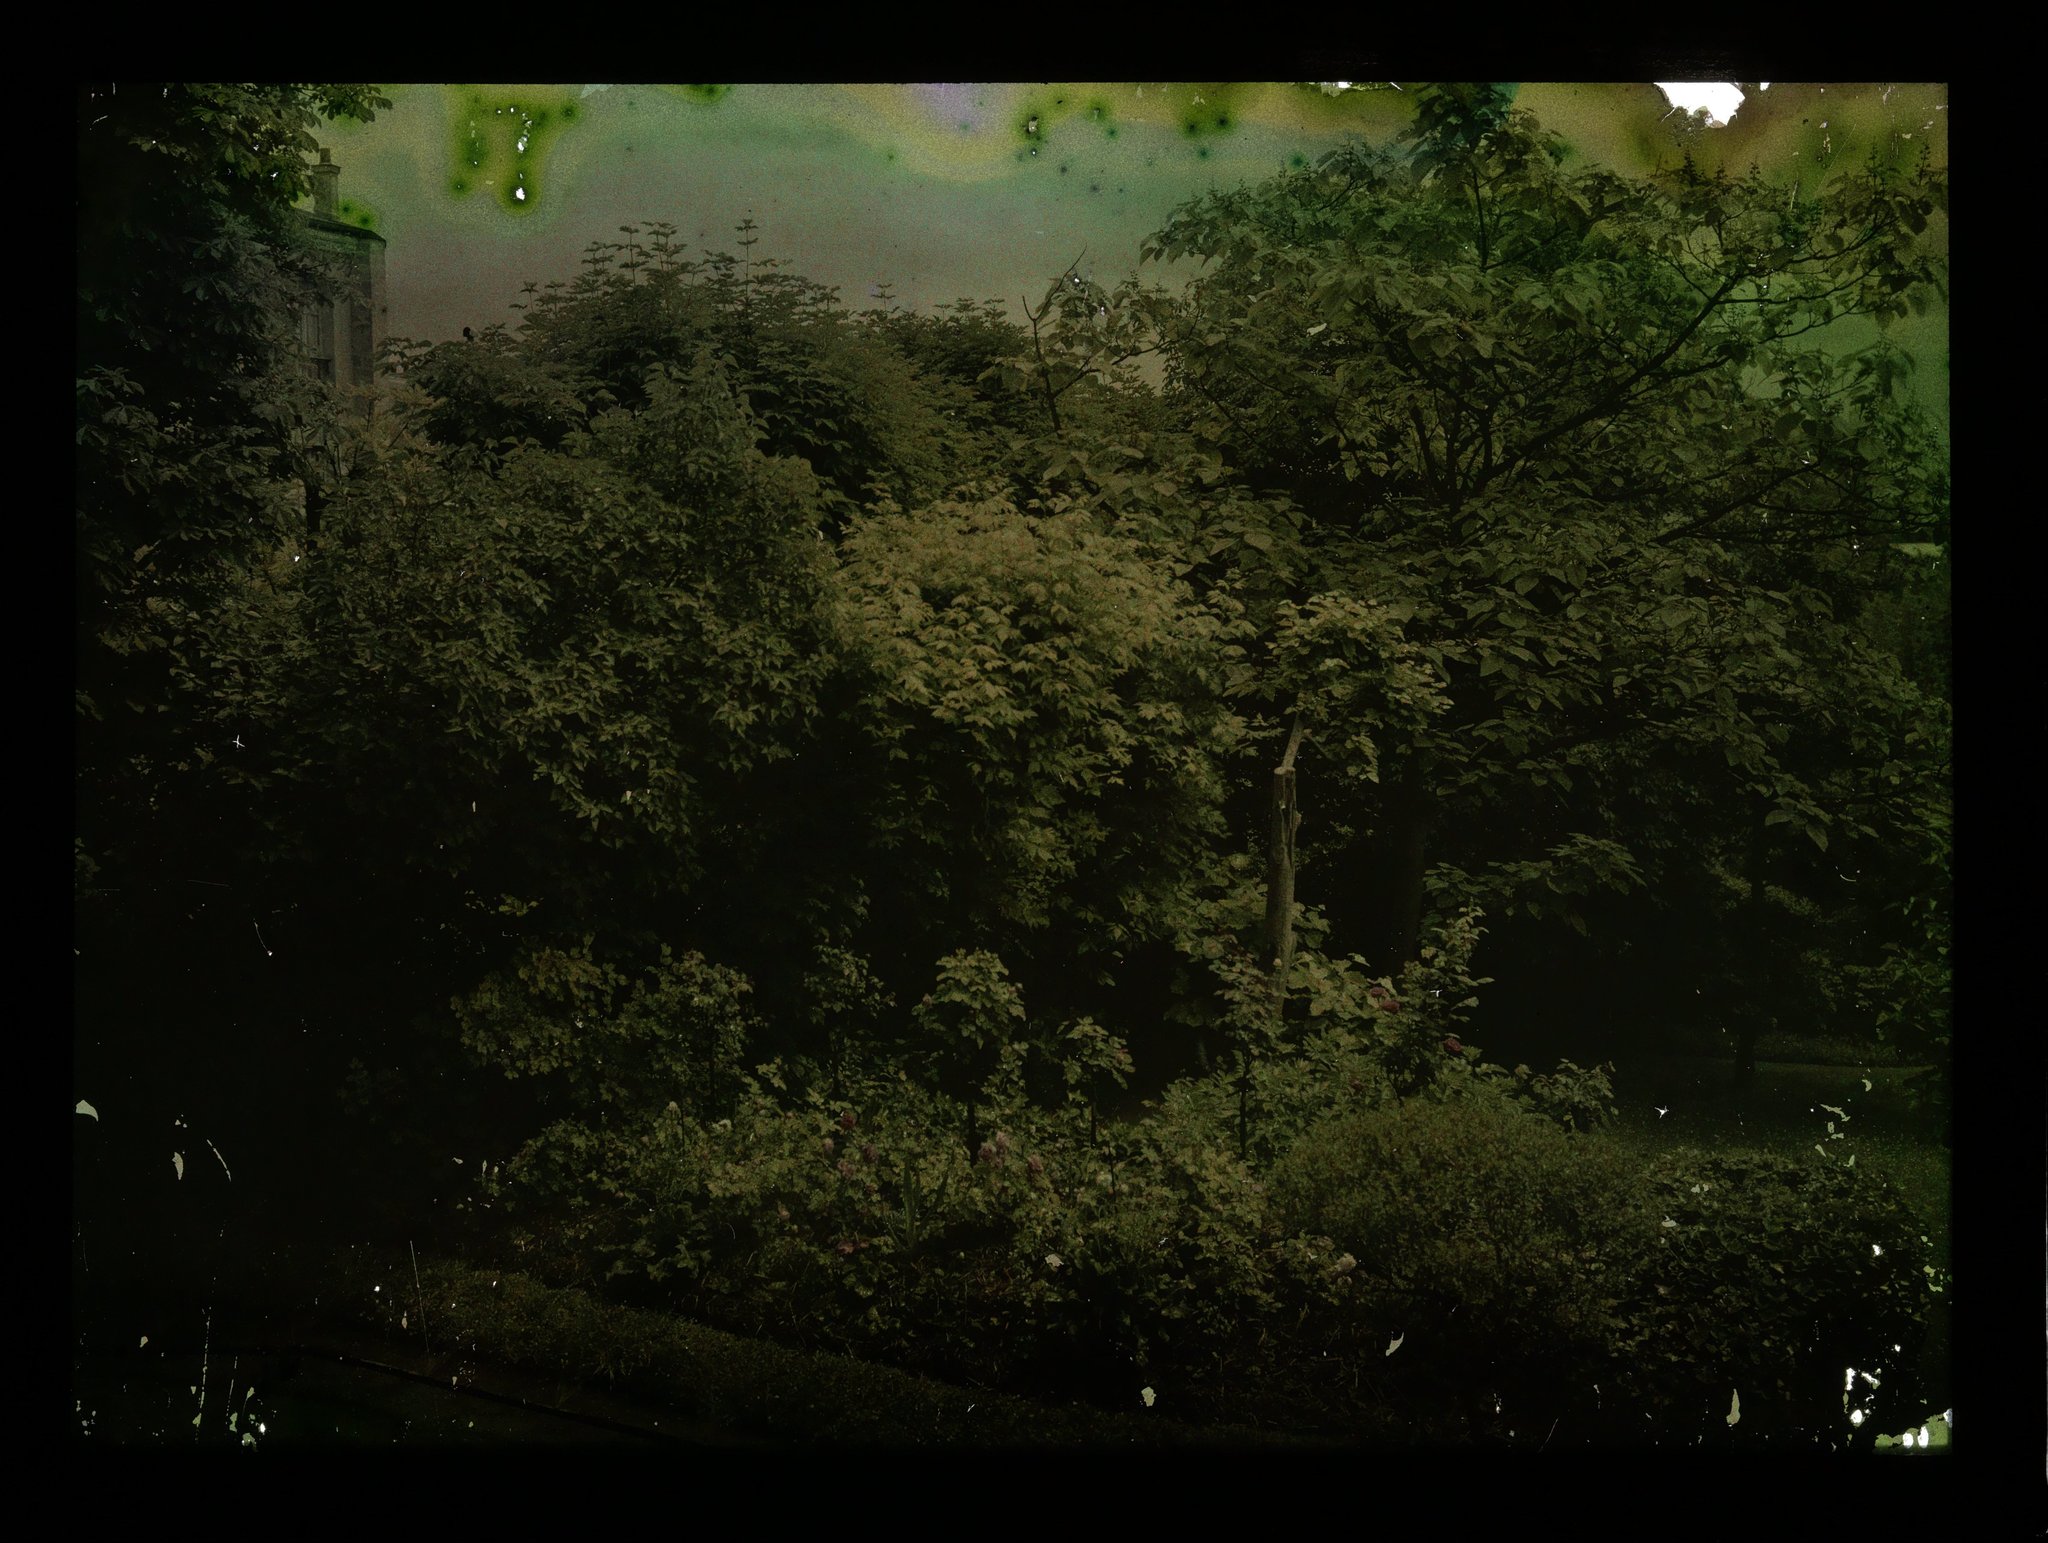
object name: photograph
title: Park met bomen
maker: Anonymous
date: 1910-1940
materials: glass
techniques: autochrome process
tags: forest, wood